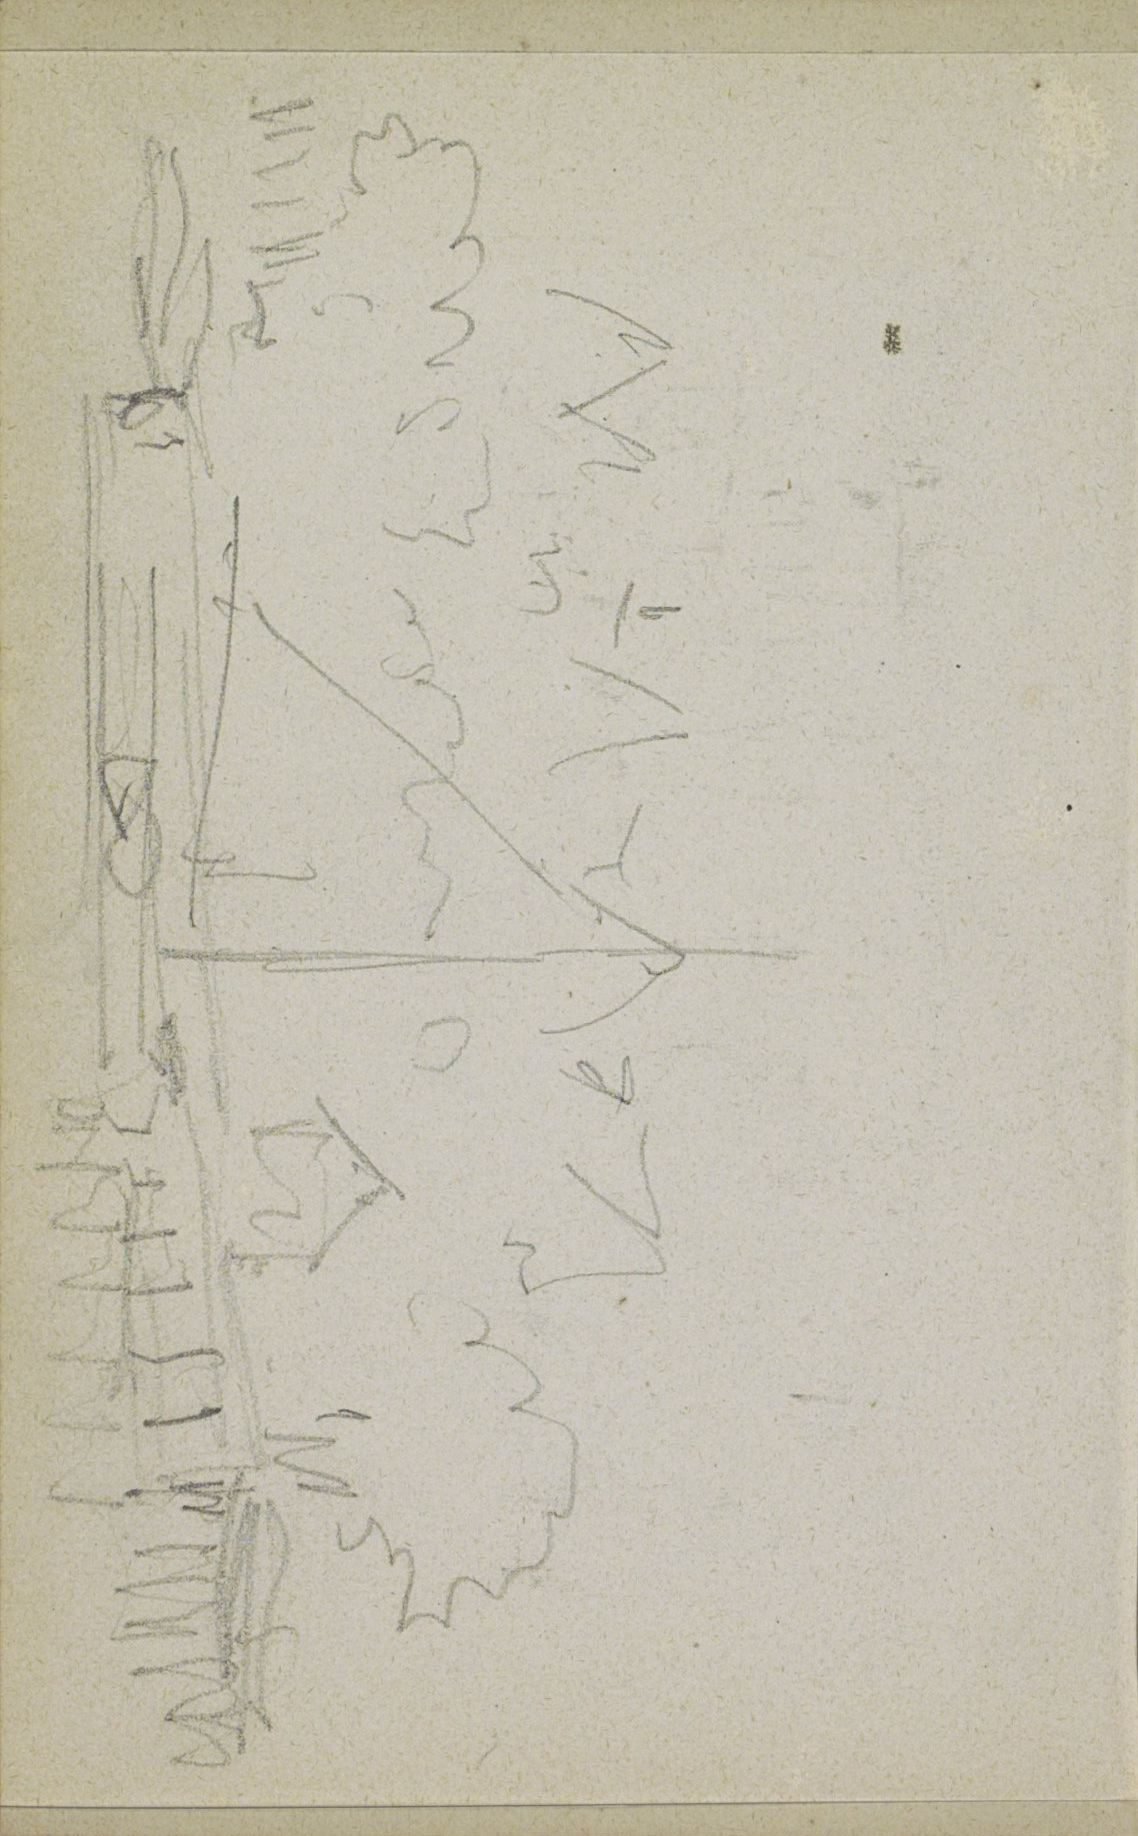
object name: sketchbook leaf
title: Gezicht op een zeilschip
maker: adrianus eversen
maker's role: draughtsman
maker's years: 1818-1897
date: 1828-1897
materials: paper, pencil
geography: netherlands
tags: sailing-ship, sailing-boat, civic architecture; edifices; dwellings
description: Gezicht op een zeilschip. Op de achtergrond een rij gebouwen. Blad 38 verso uit een schetsboek met 58 bladen.